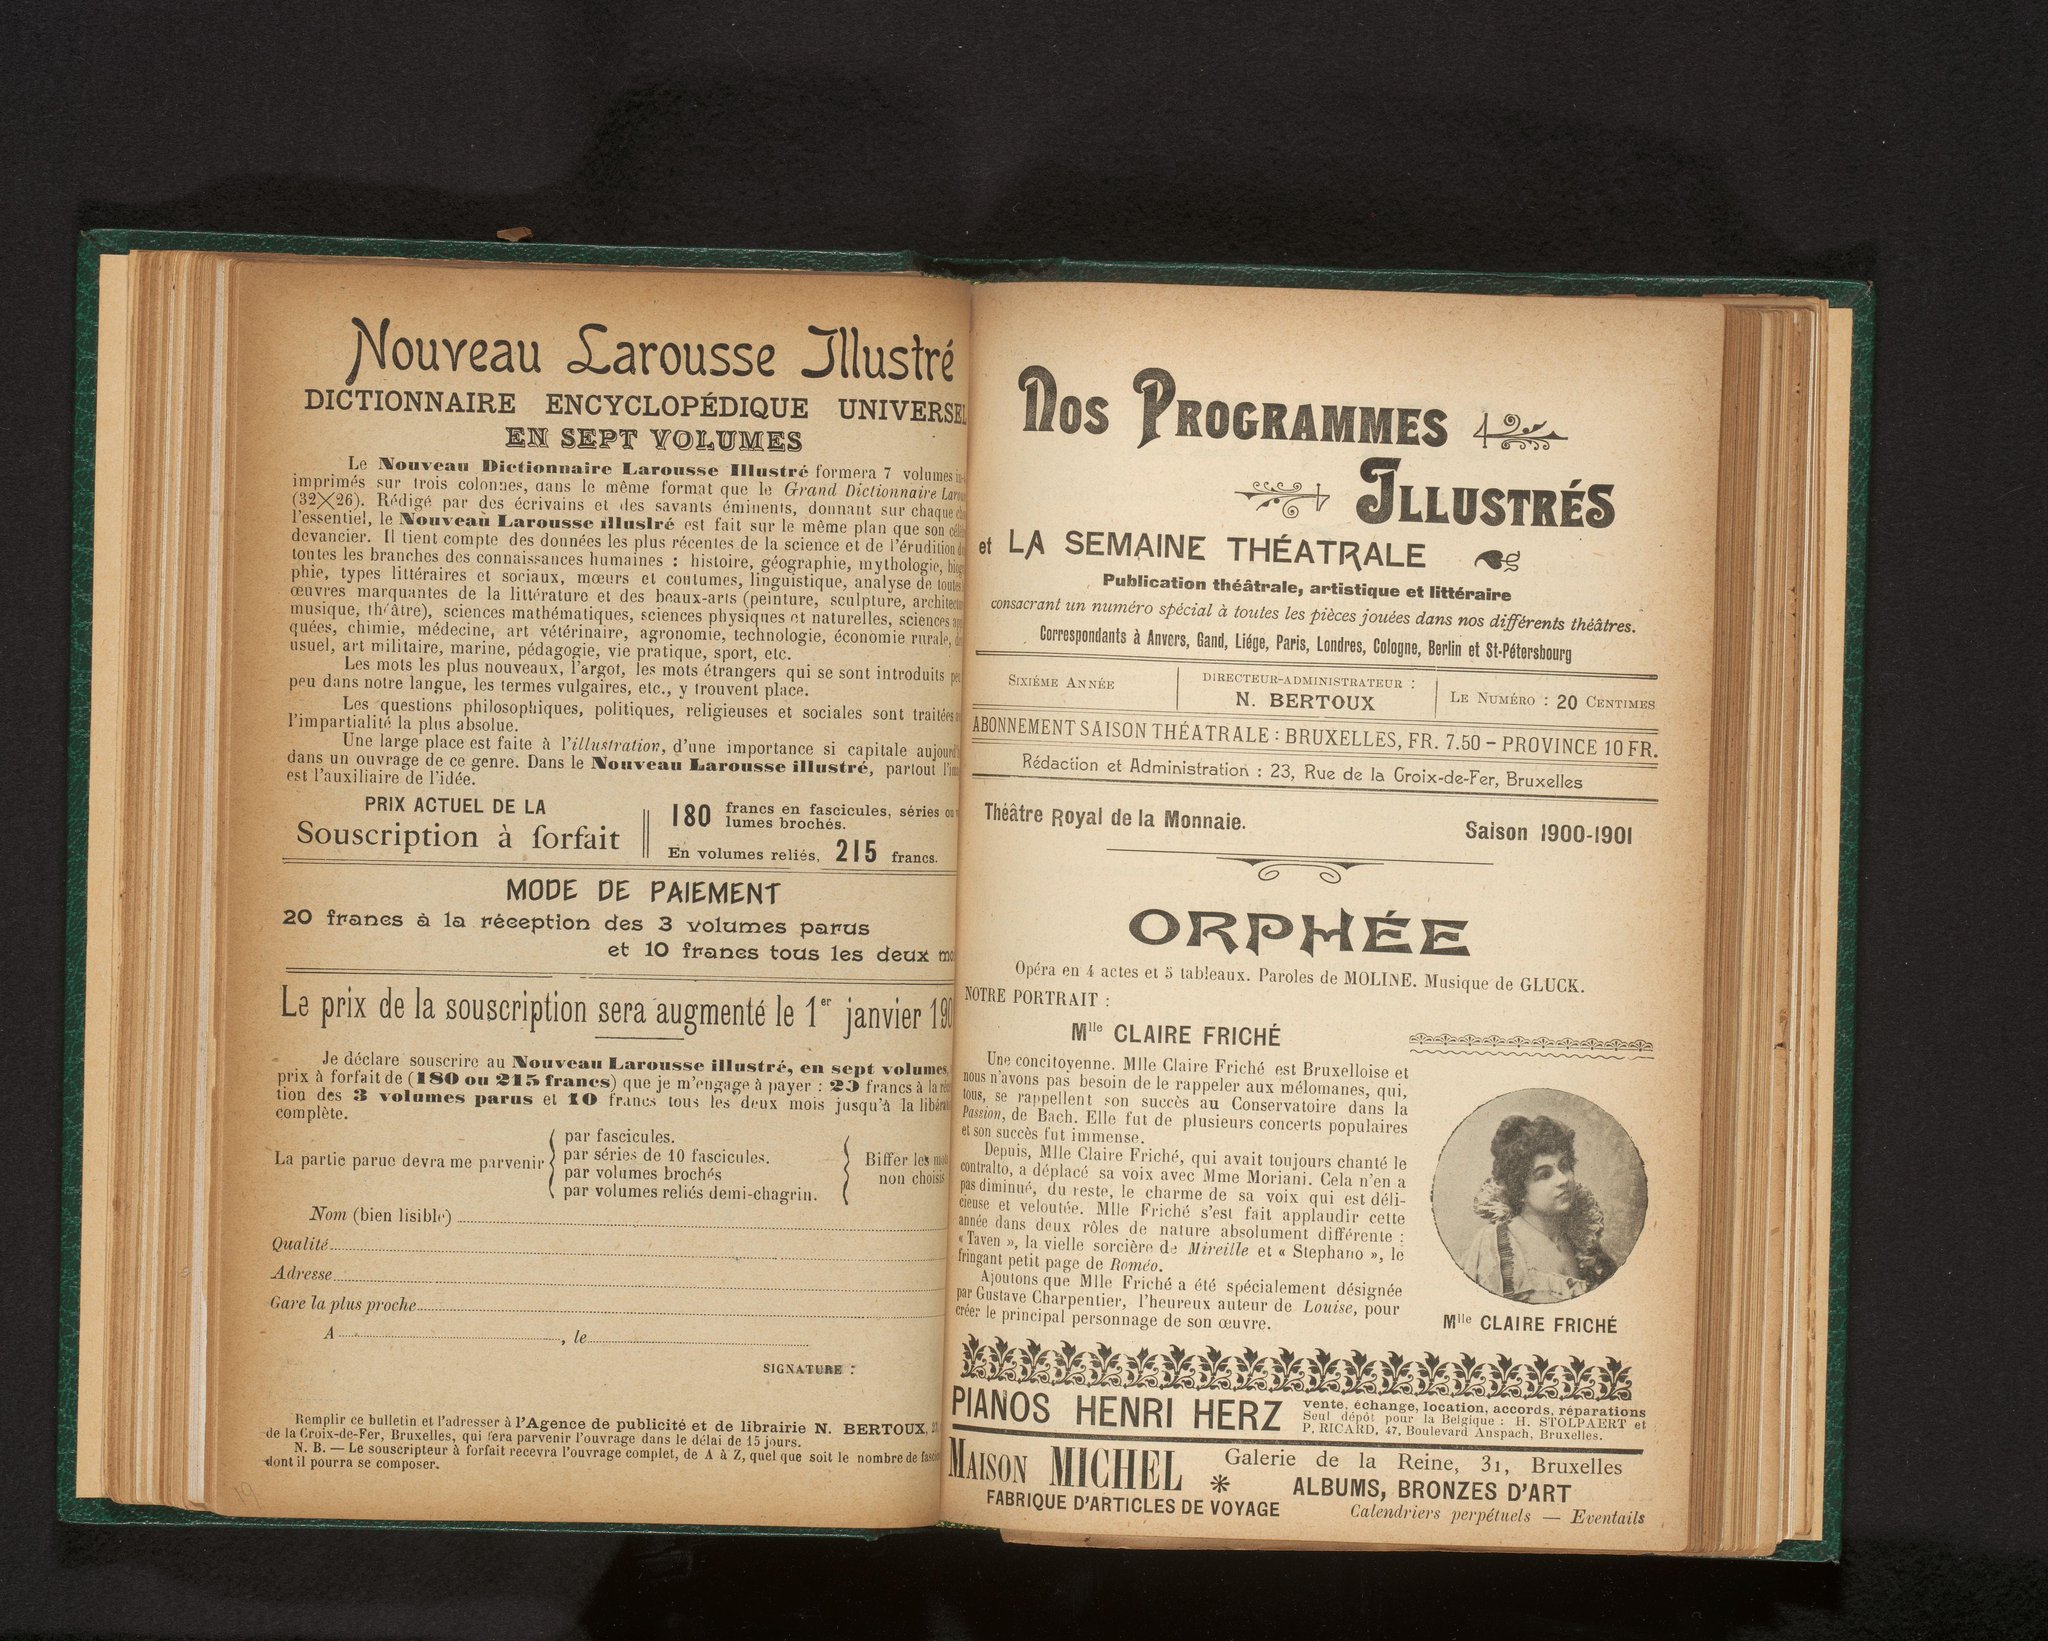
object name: photomechanical print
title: Portret van Claire Friché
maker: Anonymous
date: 1895-1900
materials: paper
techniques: autotype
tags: adult man, historical persons